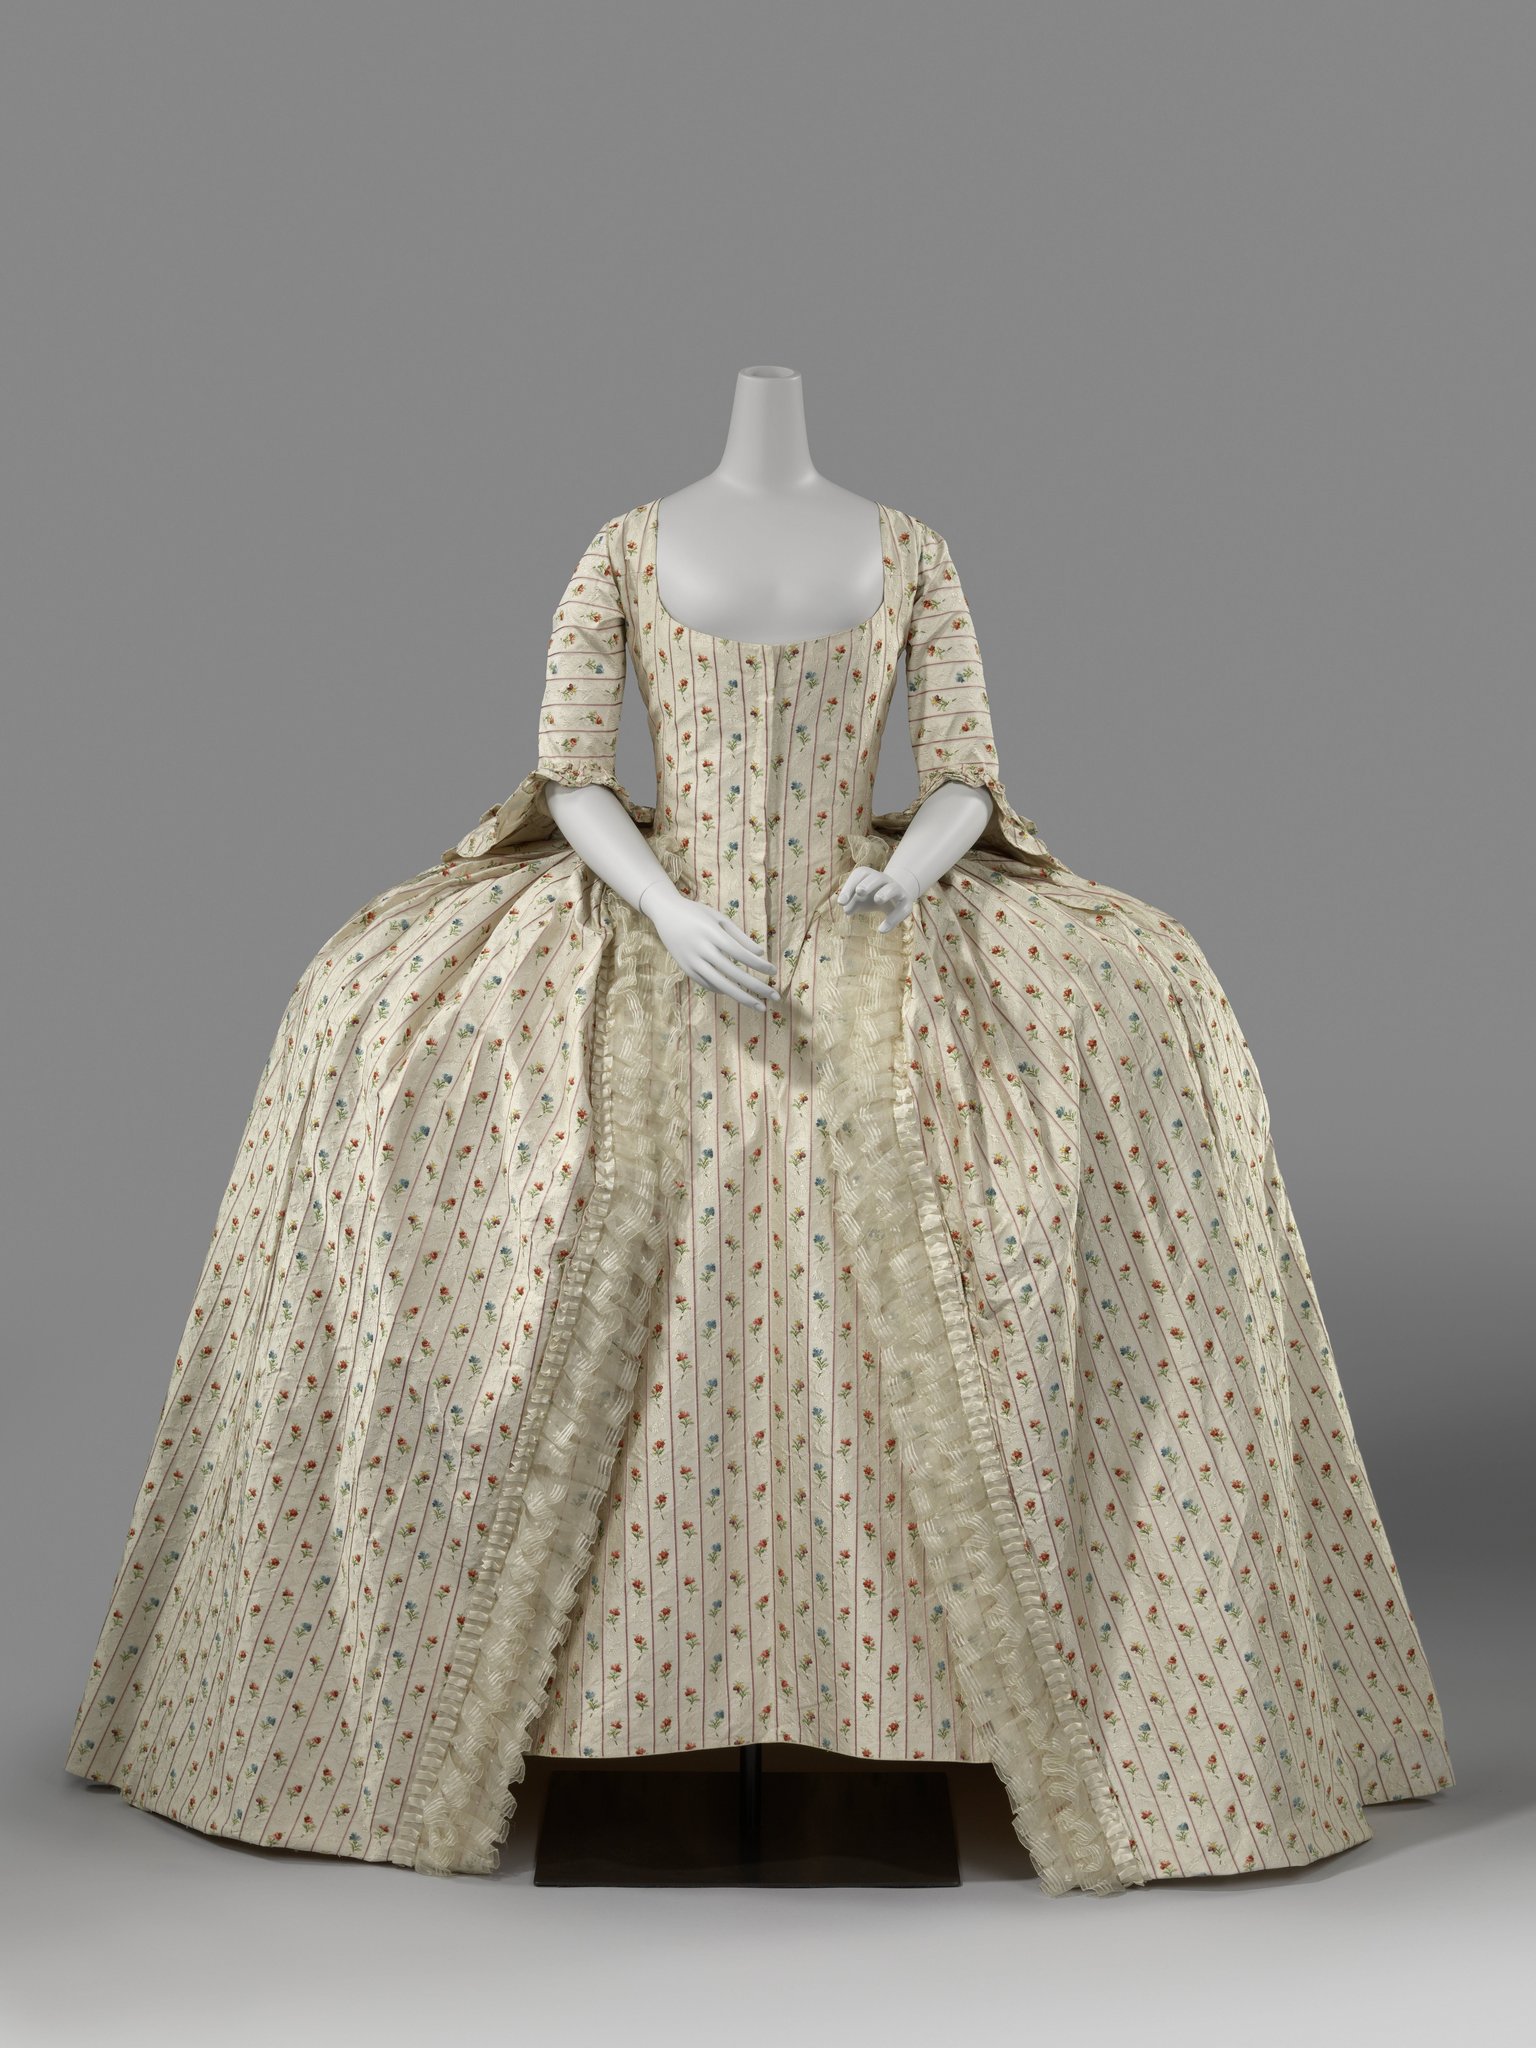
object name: clothing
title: Rok, deels van roomkleurige zijde, deels van crèmekleurige zijde met geborduurde roze strepen en meerkleurige bloemen met witte crèmekleurige strikken.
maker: Anonymous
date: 1780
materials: silk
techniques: embroidered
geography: netherlands